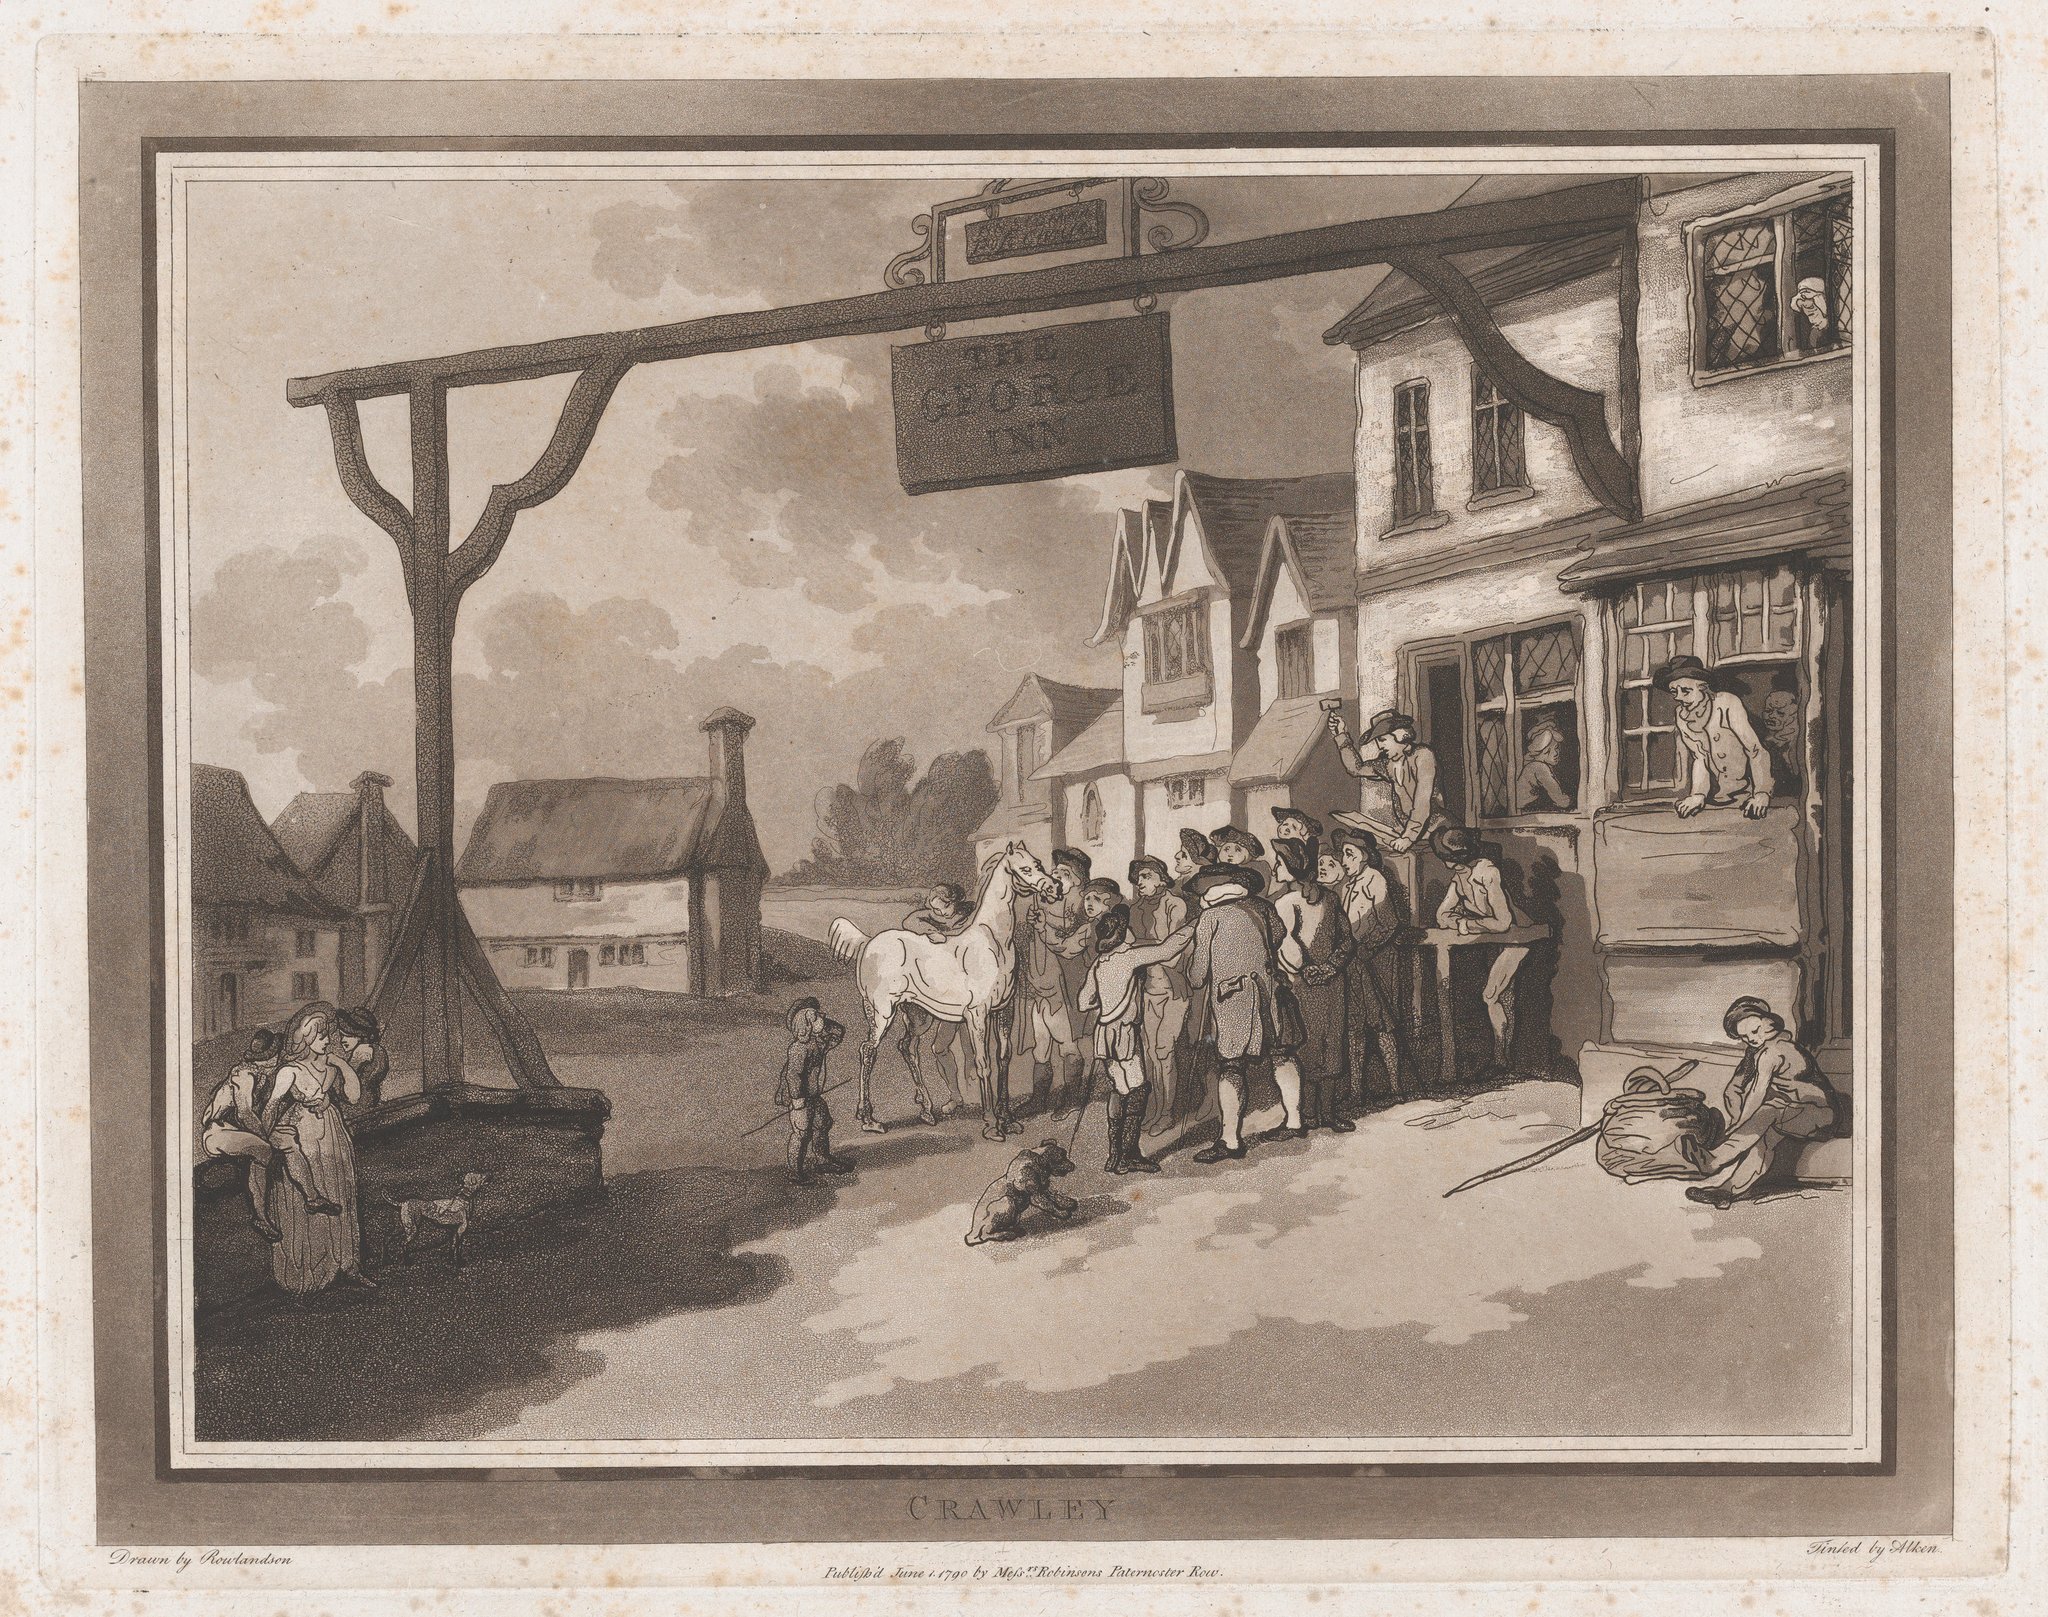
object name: print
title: Crawley (An Excursion to Brighthelmstone)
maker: thomas rowlandson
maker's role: artist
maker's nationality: british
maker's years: 1757-1827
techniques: aquatint, etching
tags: inns,towns,men,horses